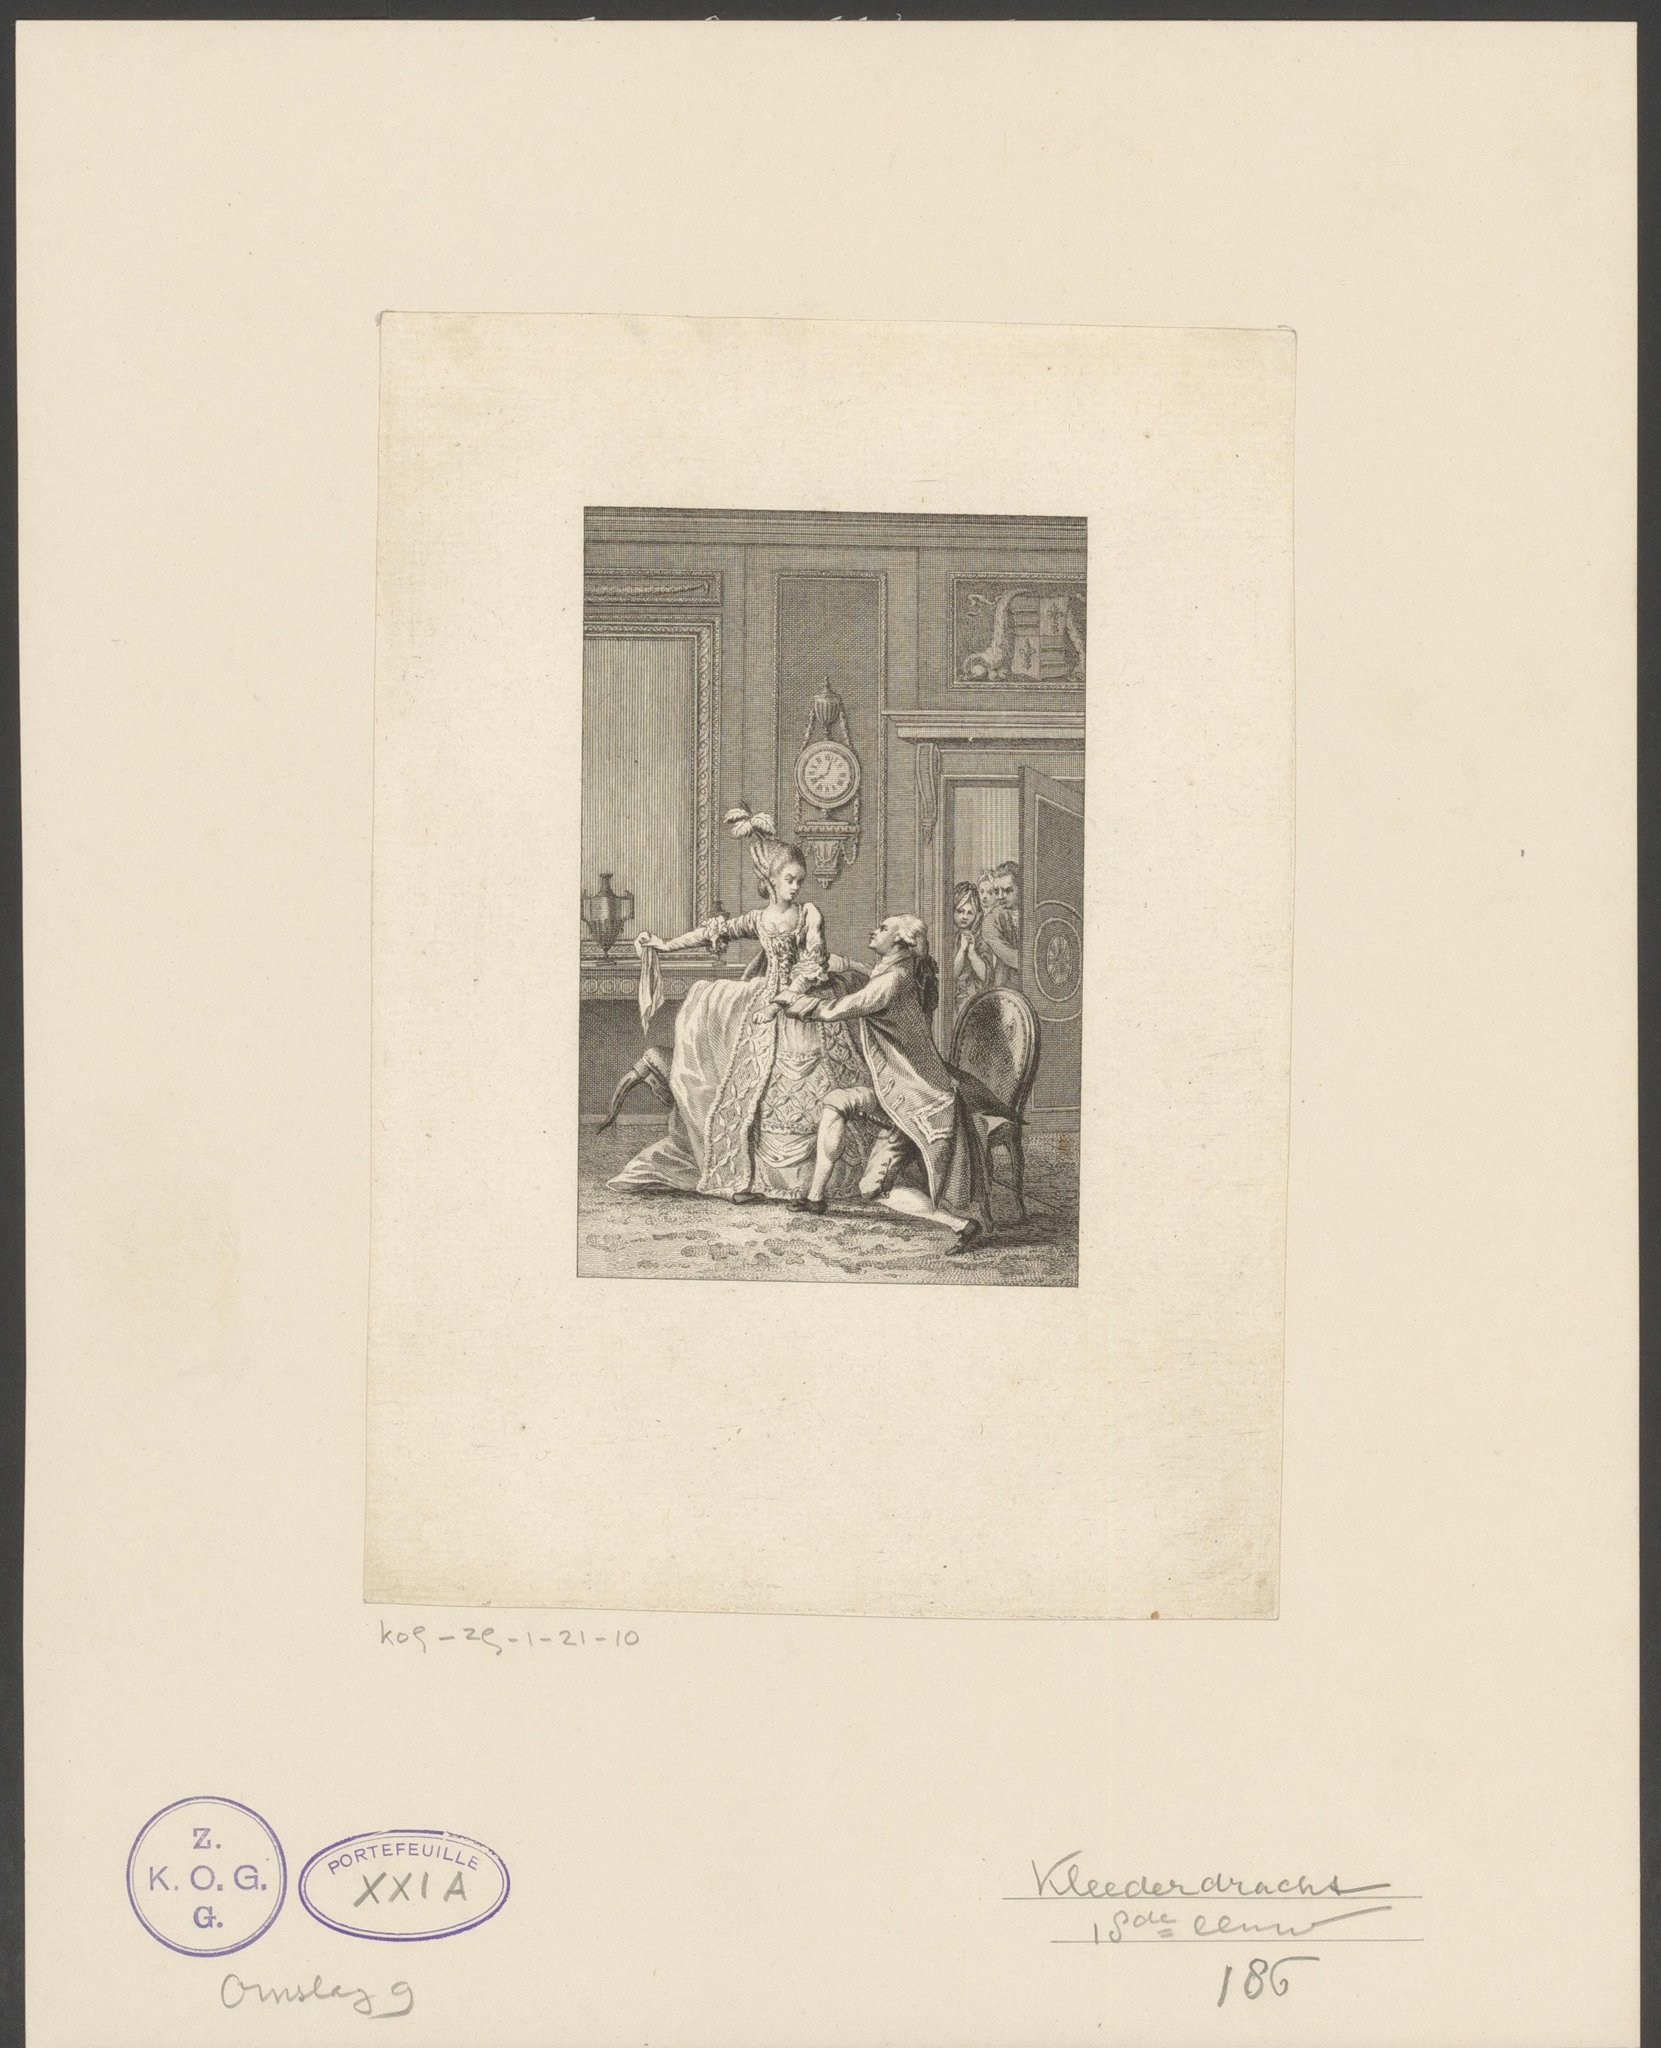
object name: print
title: Knielende man bij een boze dame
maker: reinier vinkeles (i)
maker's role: draughtsman, print maker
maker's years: 1741-1816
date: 1777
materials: paper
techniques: engraving, etching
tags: dress, gown: court gown or court dress, handkerchief, spying on someone, kneeling figure, rage, anger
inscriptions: stamp, collector's mark: Lugt 1641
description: Onderwerpsrubrieken binnen de Atlas Zeden en Gewoonten: Zeden en Gewoonten in Engeren Zin, De Kleeding, Kleederdrachten (tijdvakken), De 18de eeuw (de pruikentijd). Mannen en vrouwen.